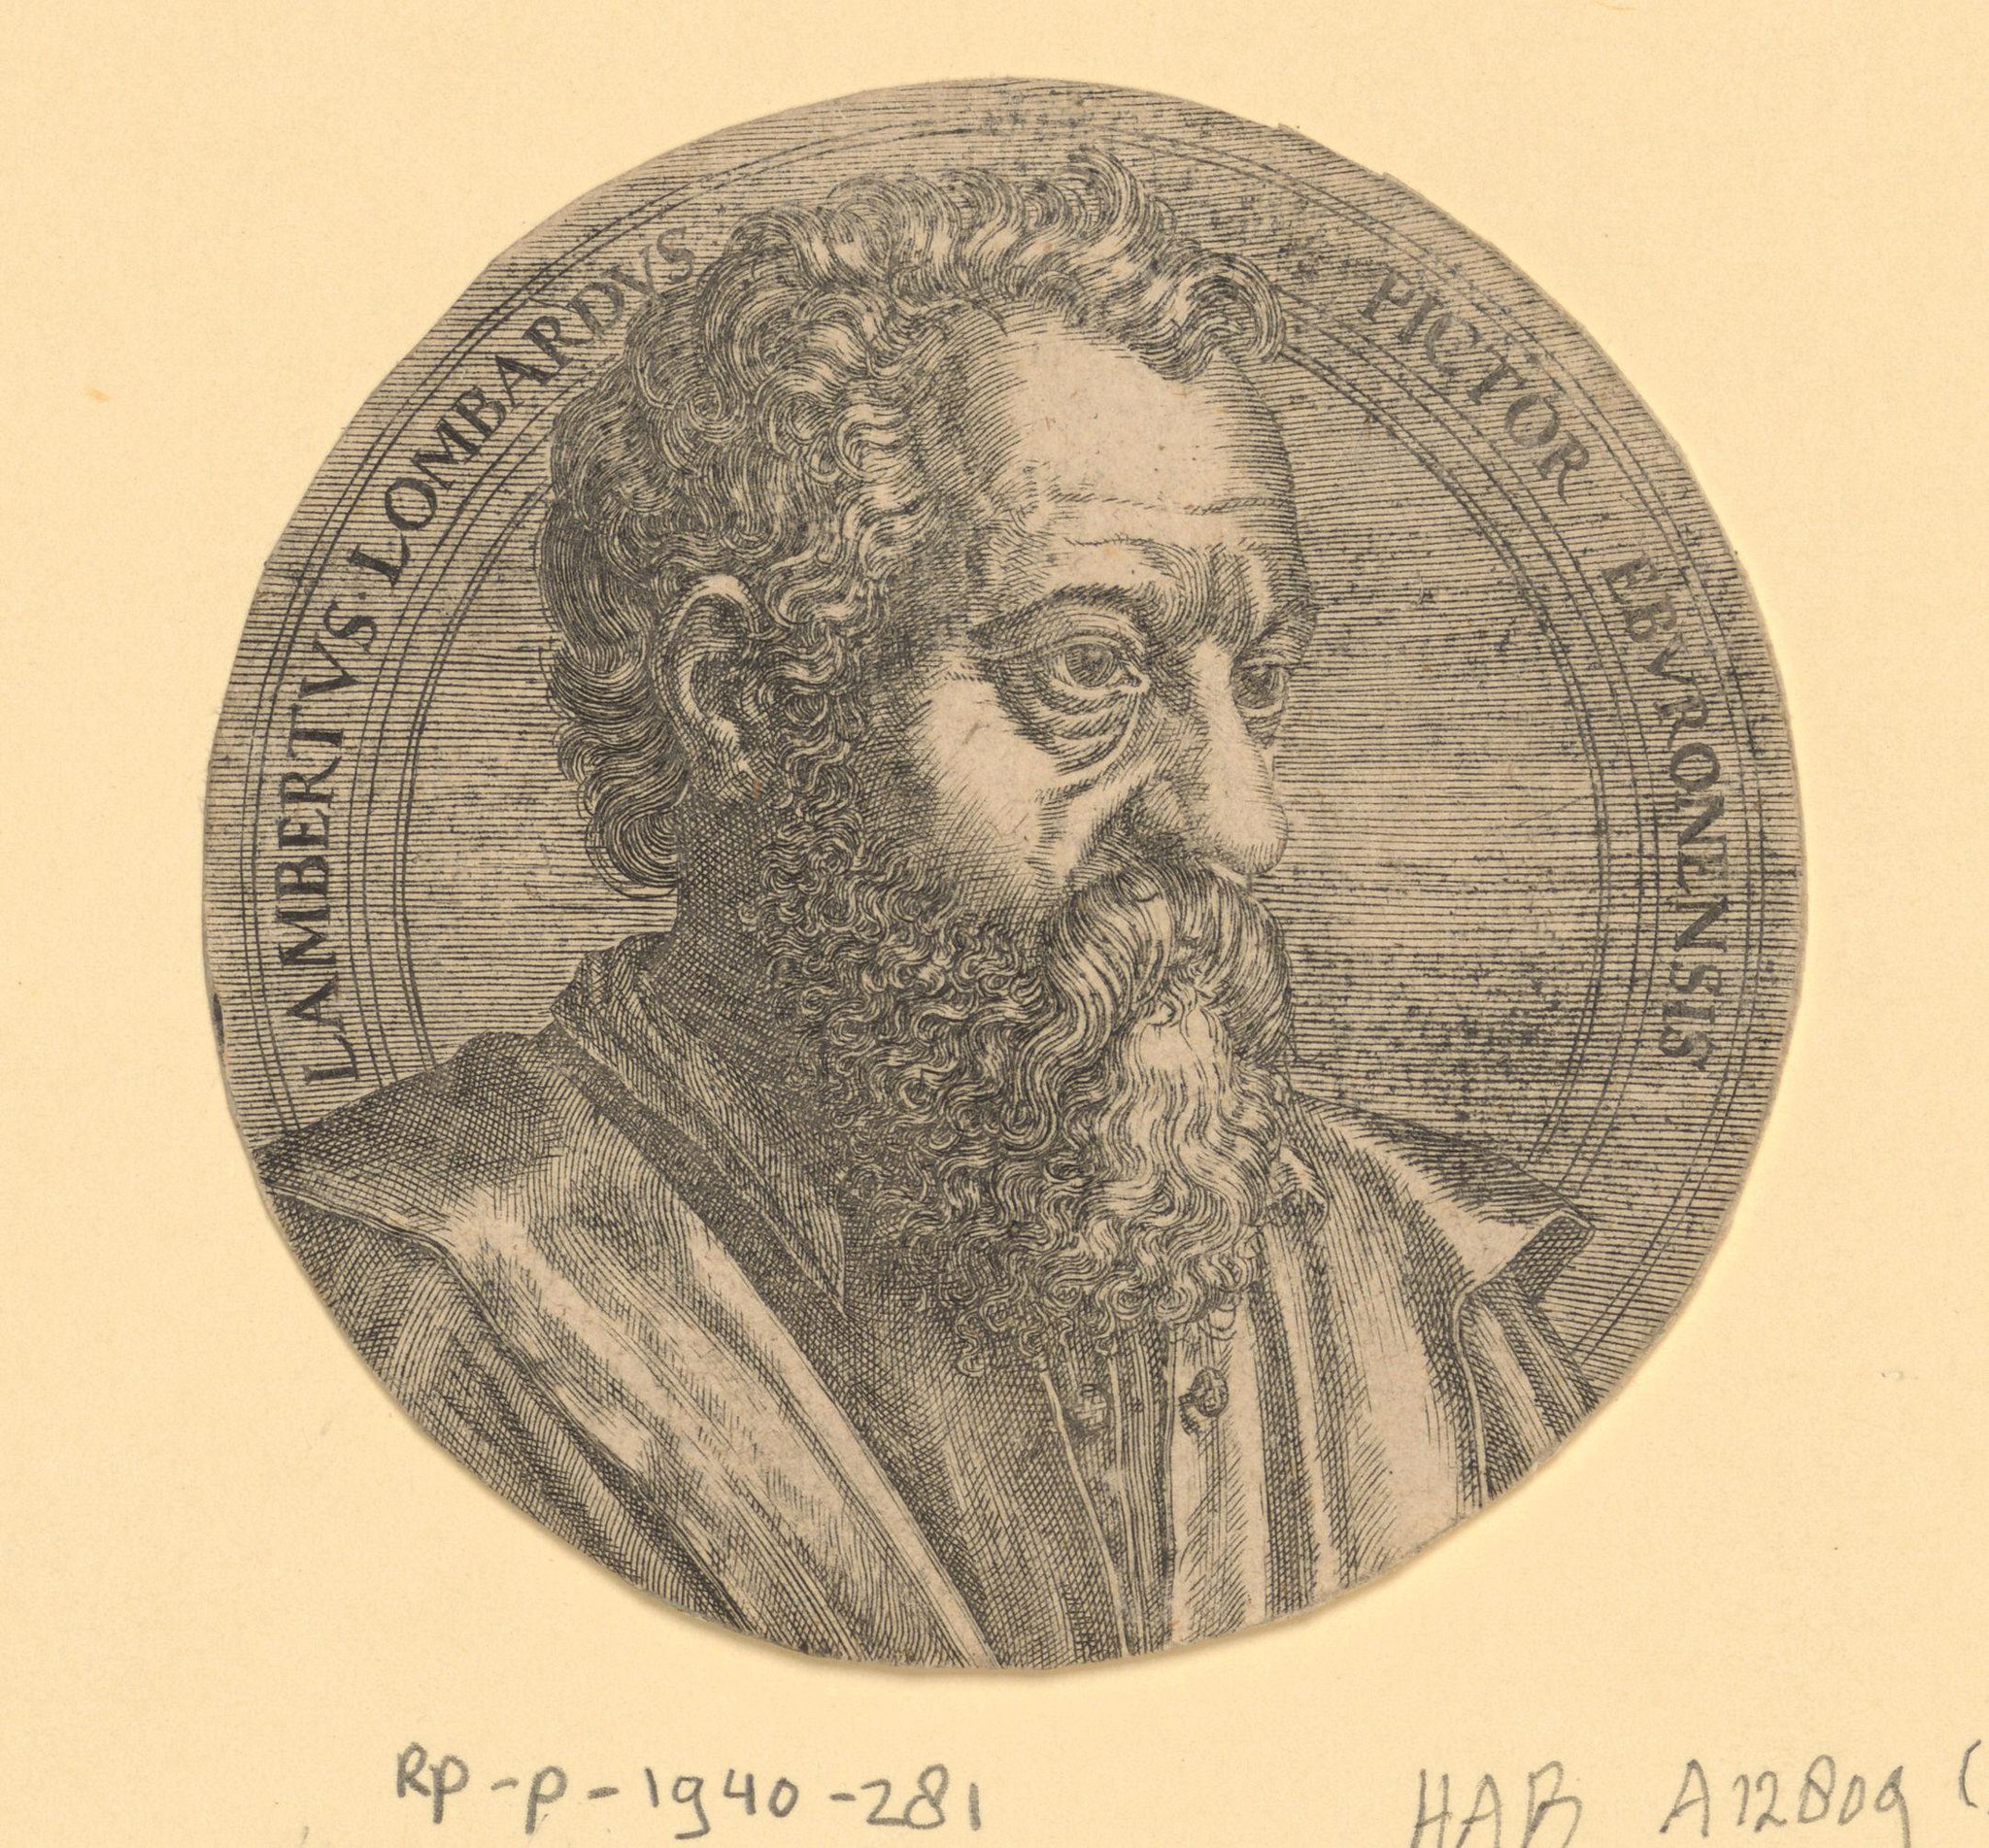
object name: print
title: Portret van Lambert Lombard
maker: lambertus suavius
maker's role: print maker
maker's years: 1514-1564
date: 1550-1564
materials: paper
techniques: engraving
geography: southern netherlands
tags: liège, print maker, draughtsman, lambert lombard, historical persons, portrait, self-portrait of painter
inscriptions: collector's mark: Lugt 2228, collector's mark: Lugt 2760